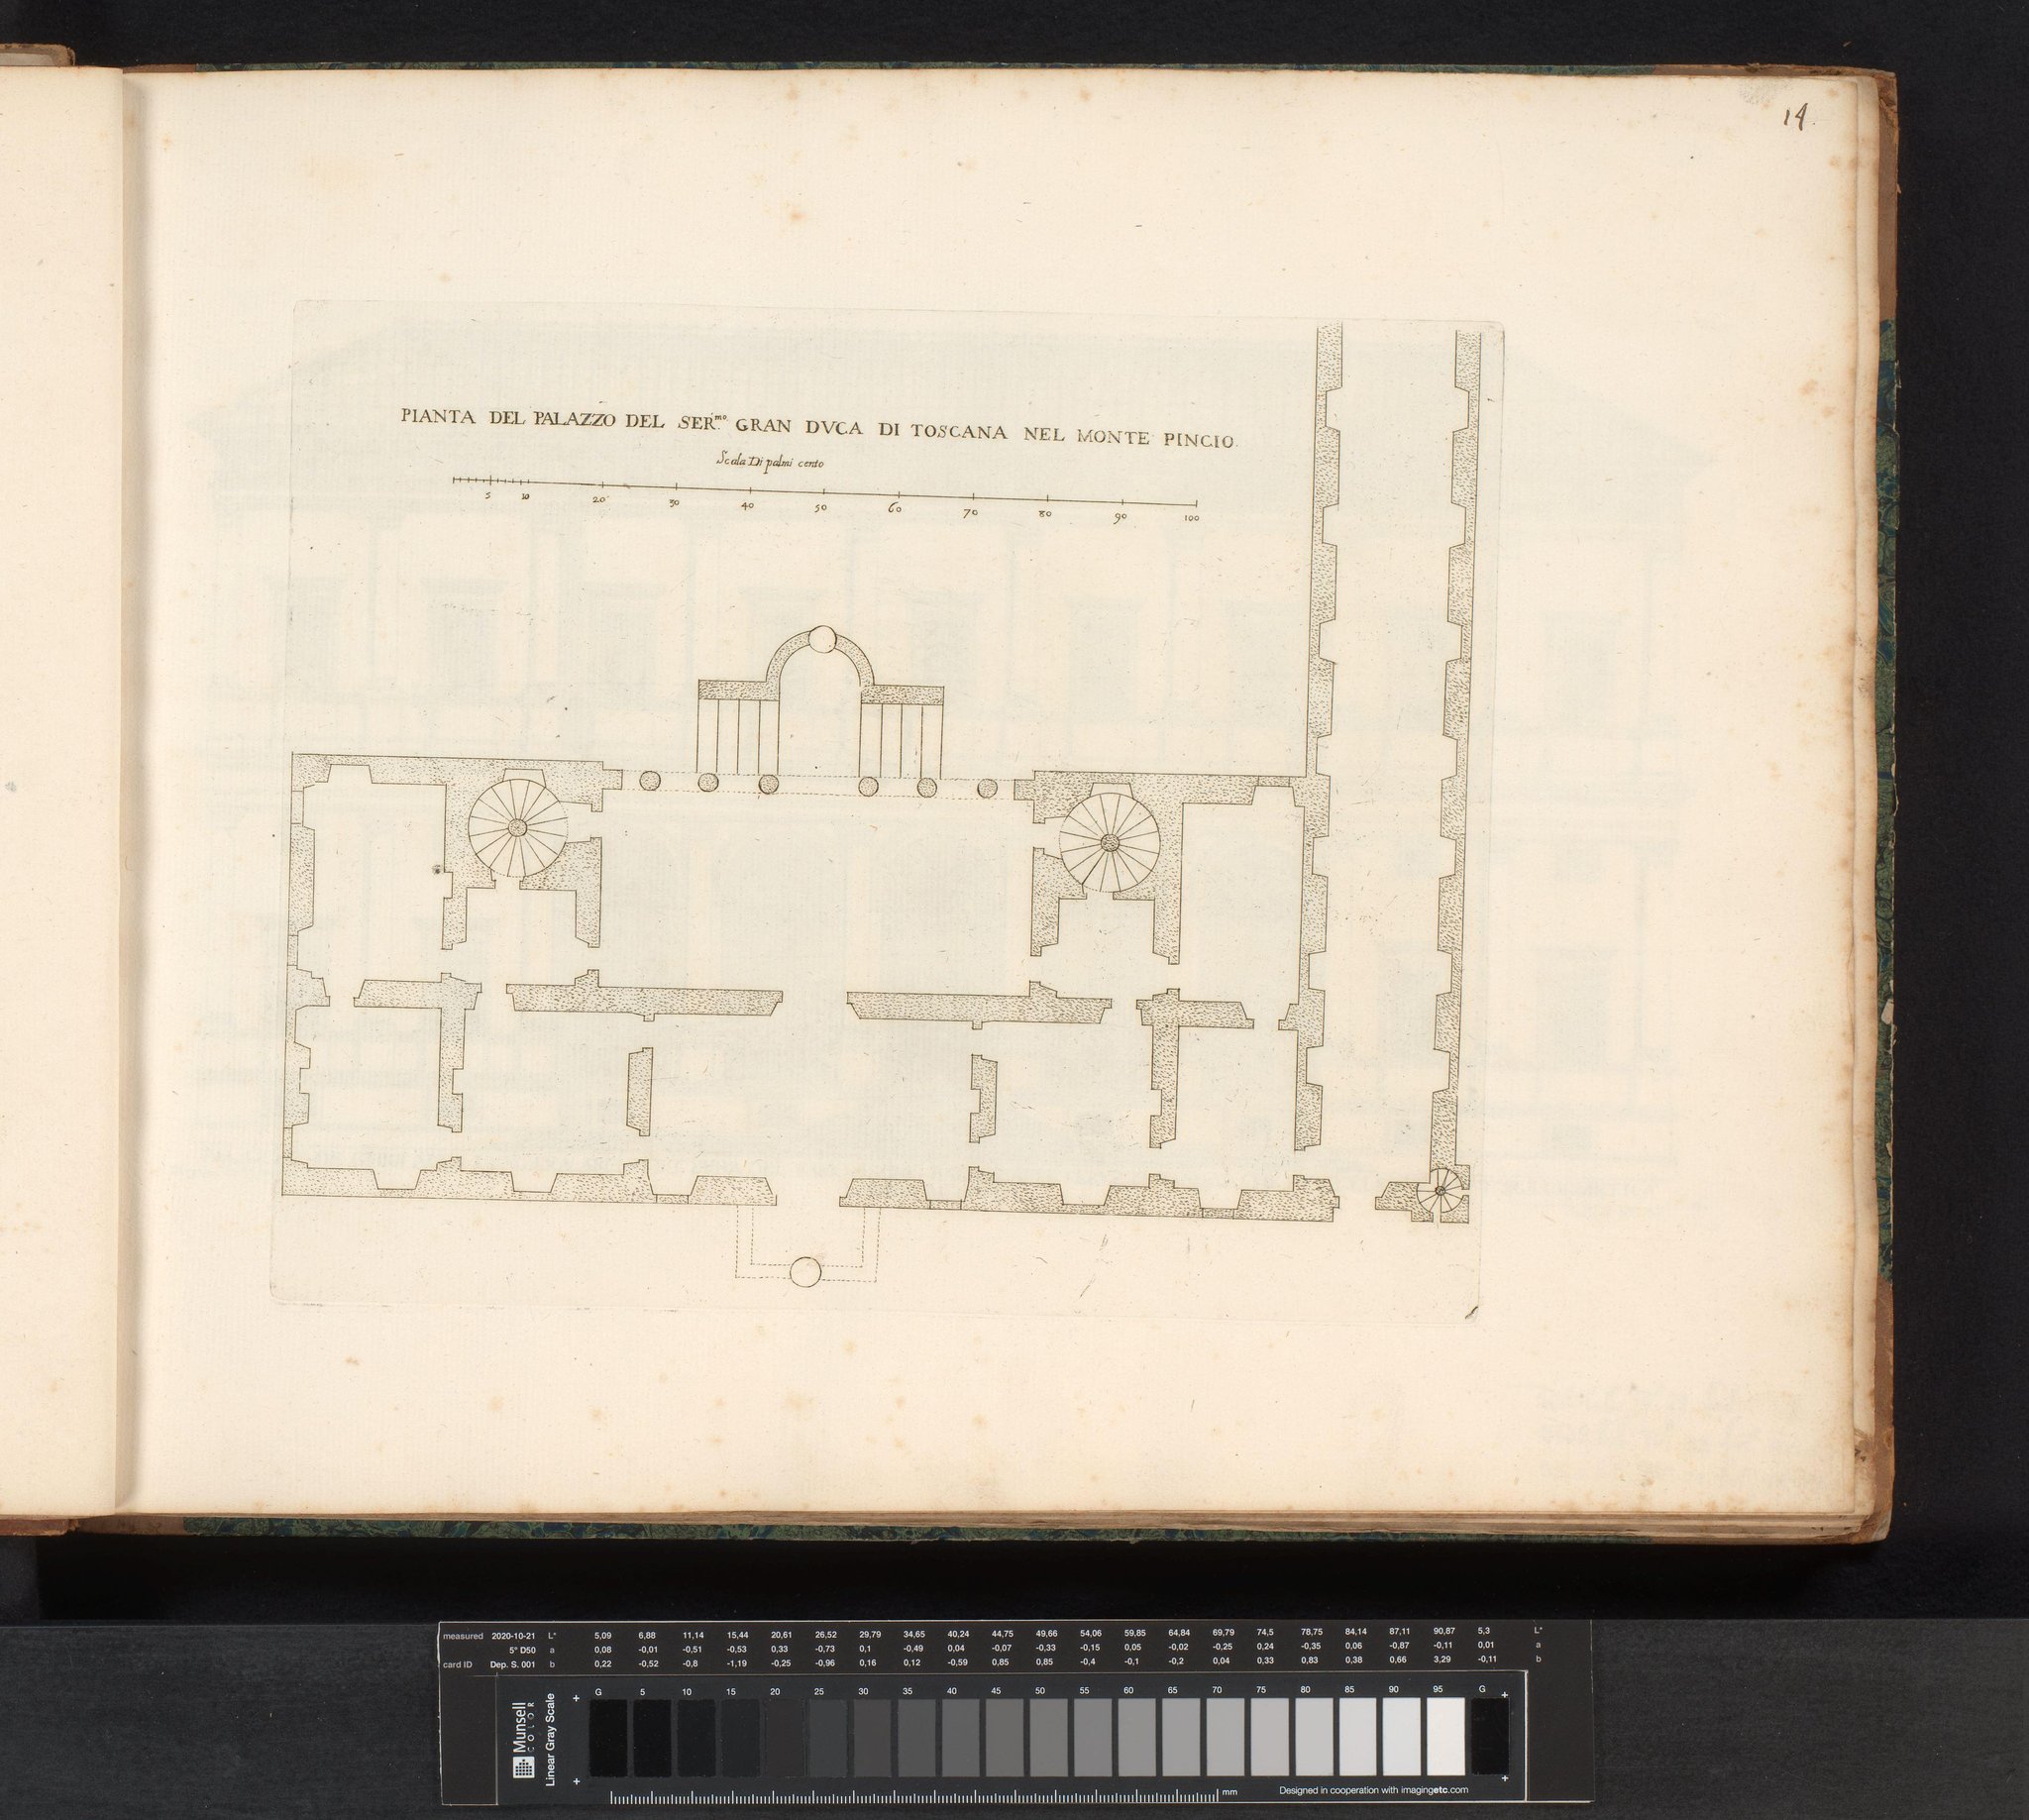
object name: print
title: Pianta del palazzo del ser.mo gran duca di Toscana nel Monte Pincio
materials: paper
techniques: etching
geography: rome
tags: palace, plan ~ architecture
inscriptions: number: ‘14’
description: Deze prent maakt deel uit van de reeks getiteld: Palazzi di Roma. Deze reeks bestaat uit twee boeken. Boek één getiteld: Palazzi di Roma dei più celebri architetti..., bestaat uit 44 prenten die worden toegeschreven aan Giovanni Battista Falda (naam staat enkel op prent 27) en uitgegeven door Giovanni Giacomo de'Rossi. Deze 44 prenten zijn bekend in twee staten (met en zonder nummer). Boek twee getiteld: Nuovi disegni dell'architetture... libro secondo, bevat 66 prenten door Giovanni Battista Falda en Simone Felice. Deze 66 prenten zijn bekend in twee staten (met en zonder nummer).